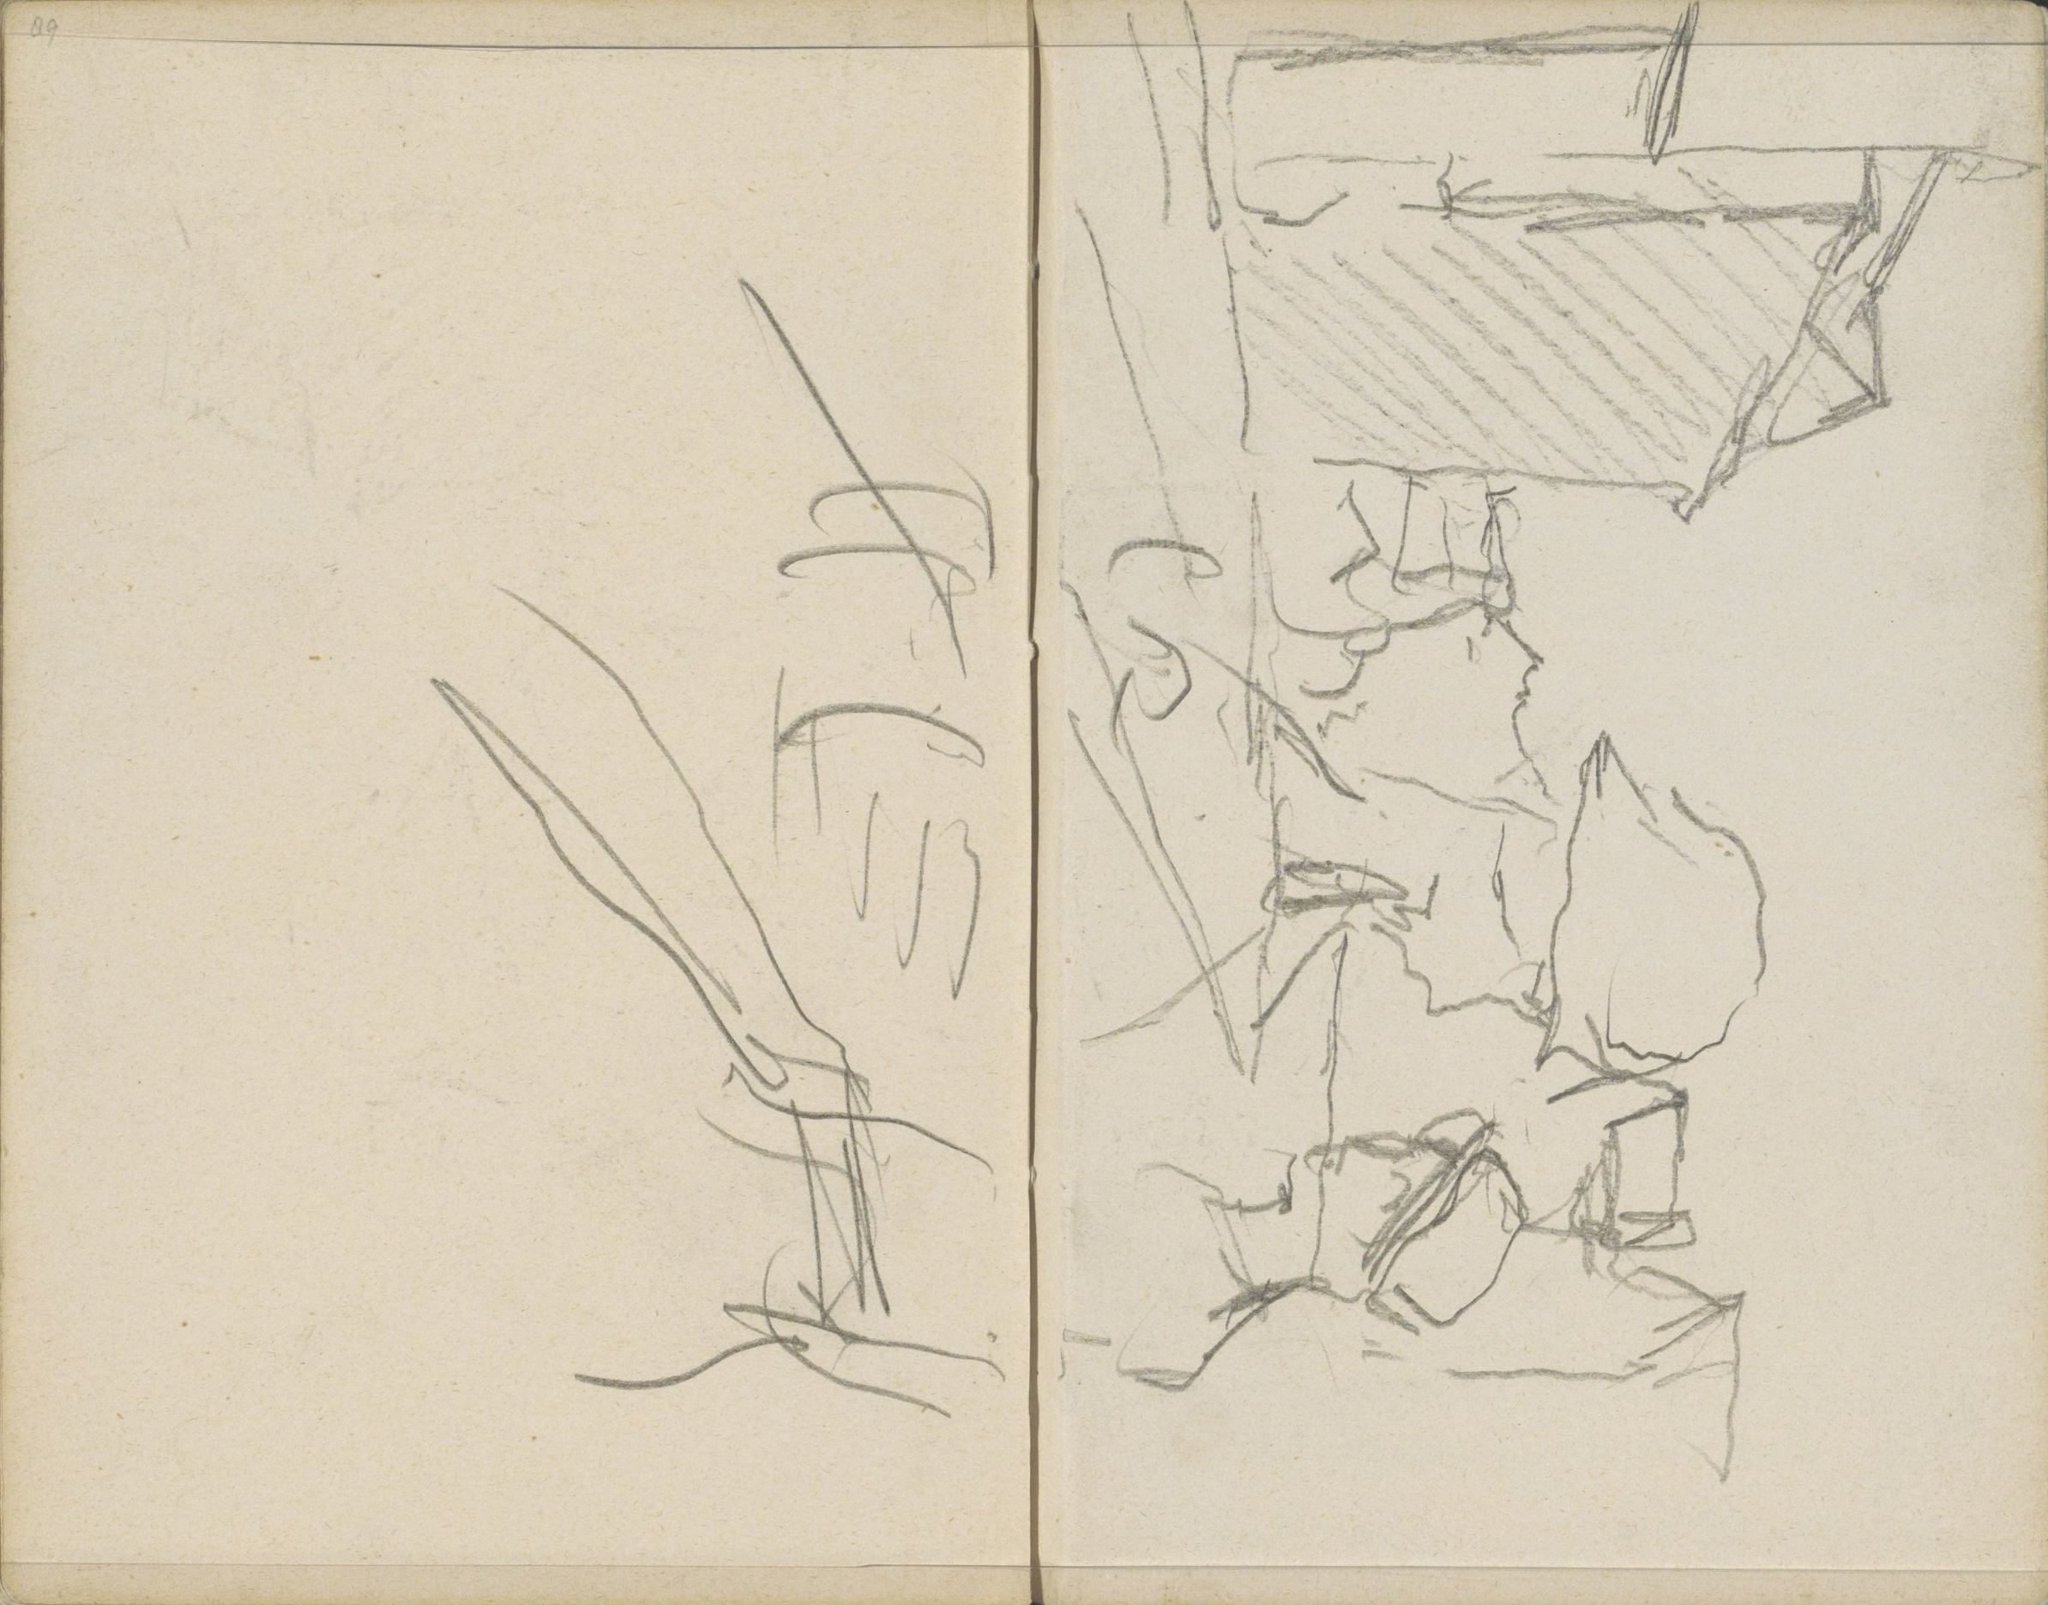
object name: sketchbook leaf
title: Twee figuren op straat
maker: george hendrik breitner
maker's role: draughtsman, painter, print maker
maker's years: 1857-1923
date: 1909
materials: paper, pencil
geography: amsterdam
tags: adult man, the soldier; the soldier's life, street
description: Twee figuren op straat. De linker figuur is mogelijk een soldaat. Pagina 89 en pagina 90 uit een schetsboek met 45 bladen vervaardigd in Amsterdam en Pittsburgh.